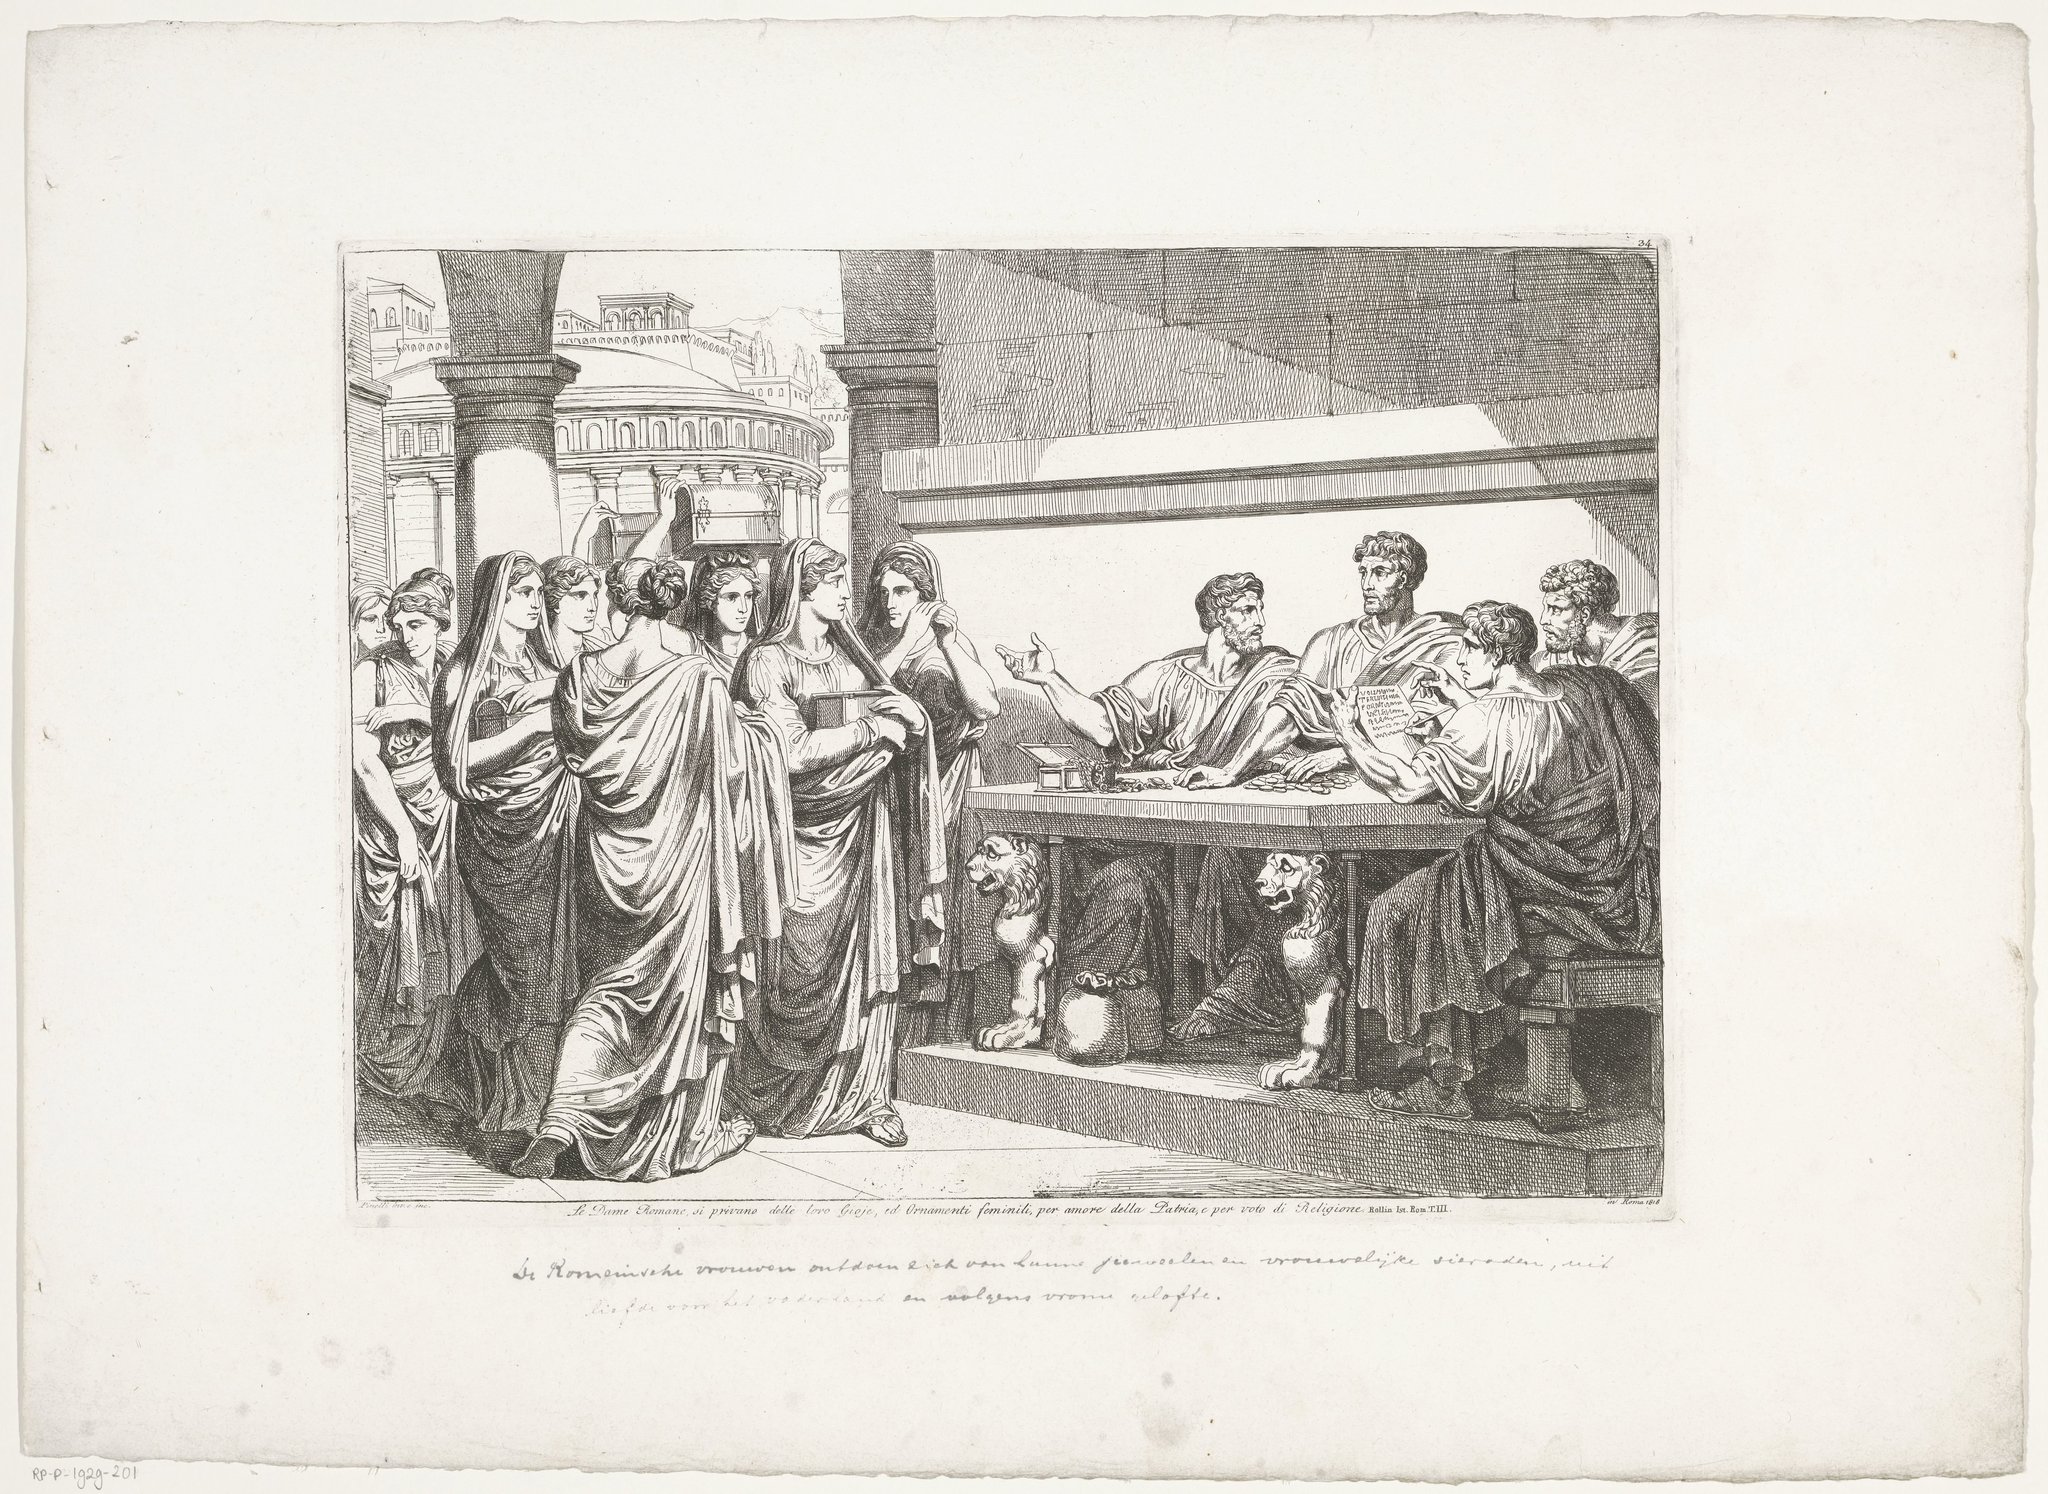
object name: print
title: Frontespizio della Istoria Romana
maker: bartolomeo pinelli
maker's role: draughtsman, print maker, sculptor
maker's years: 1781-1835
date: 1817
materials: paper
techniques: etching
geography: rome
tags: piety and generosity of the roman women: they offer their gold and jewellery in order to fulfil camillus' pledge to apollo of a golden bowl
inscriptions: inscription: ‘De Romeinsche vrouwen ontdoen zich van hunne juweelen en vrouwelijke sieraden, uit / liefde voor het vaderland en volgens vrome gelofte.’, collector's mark: Lugt 2228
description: Deze prent maakt deel uit van een reeks van 101 prenten over de geschiedenis van Rome.